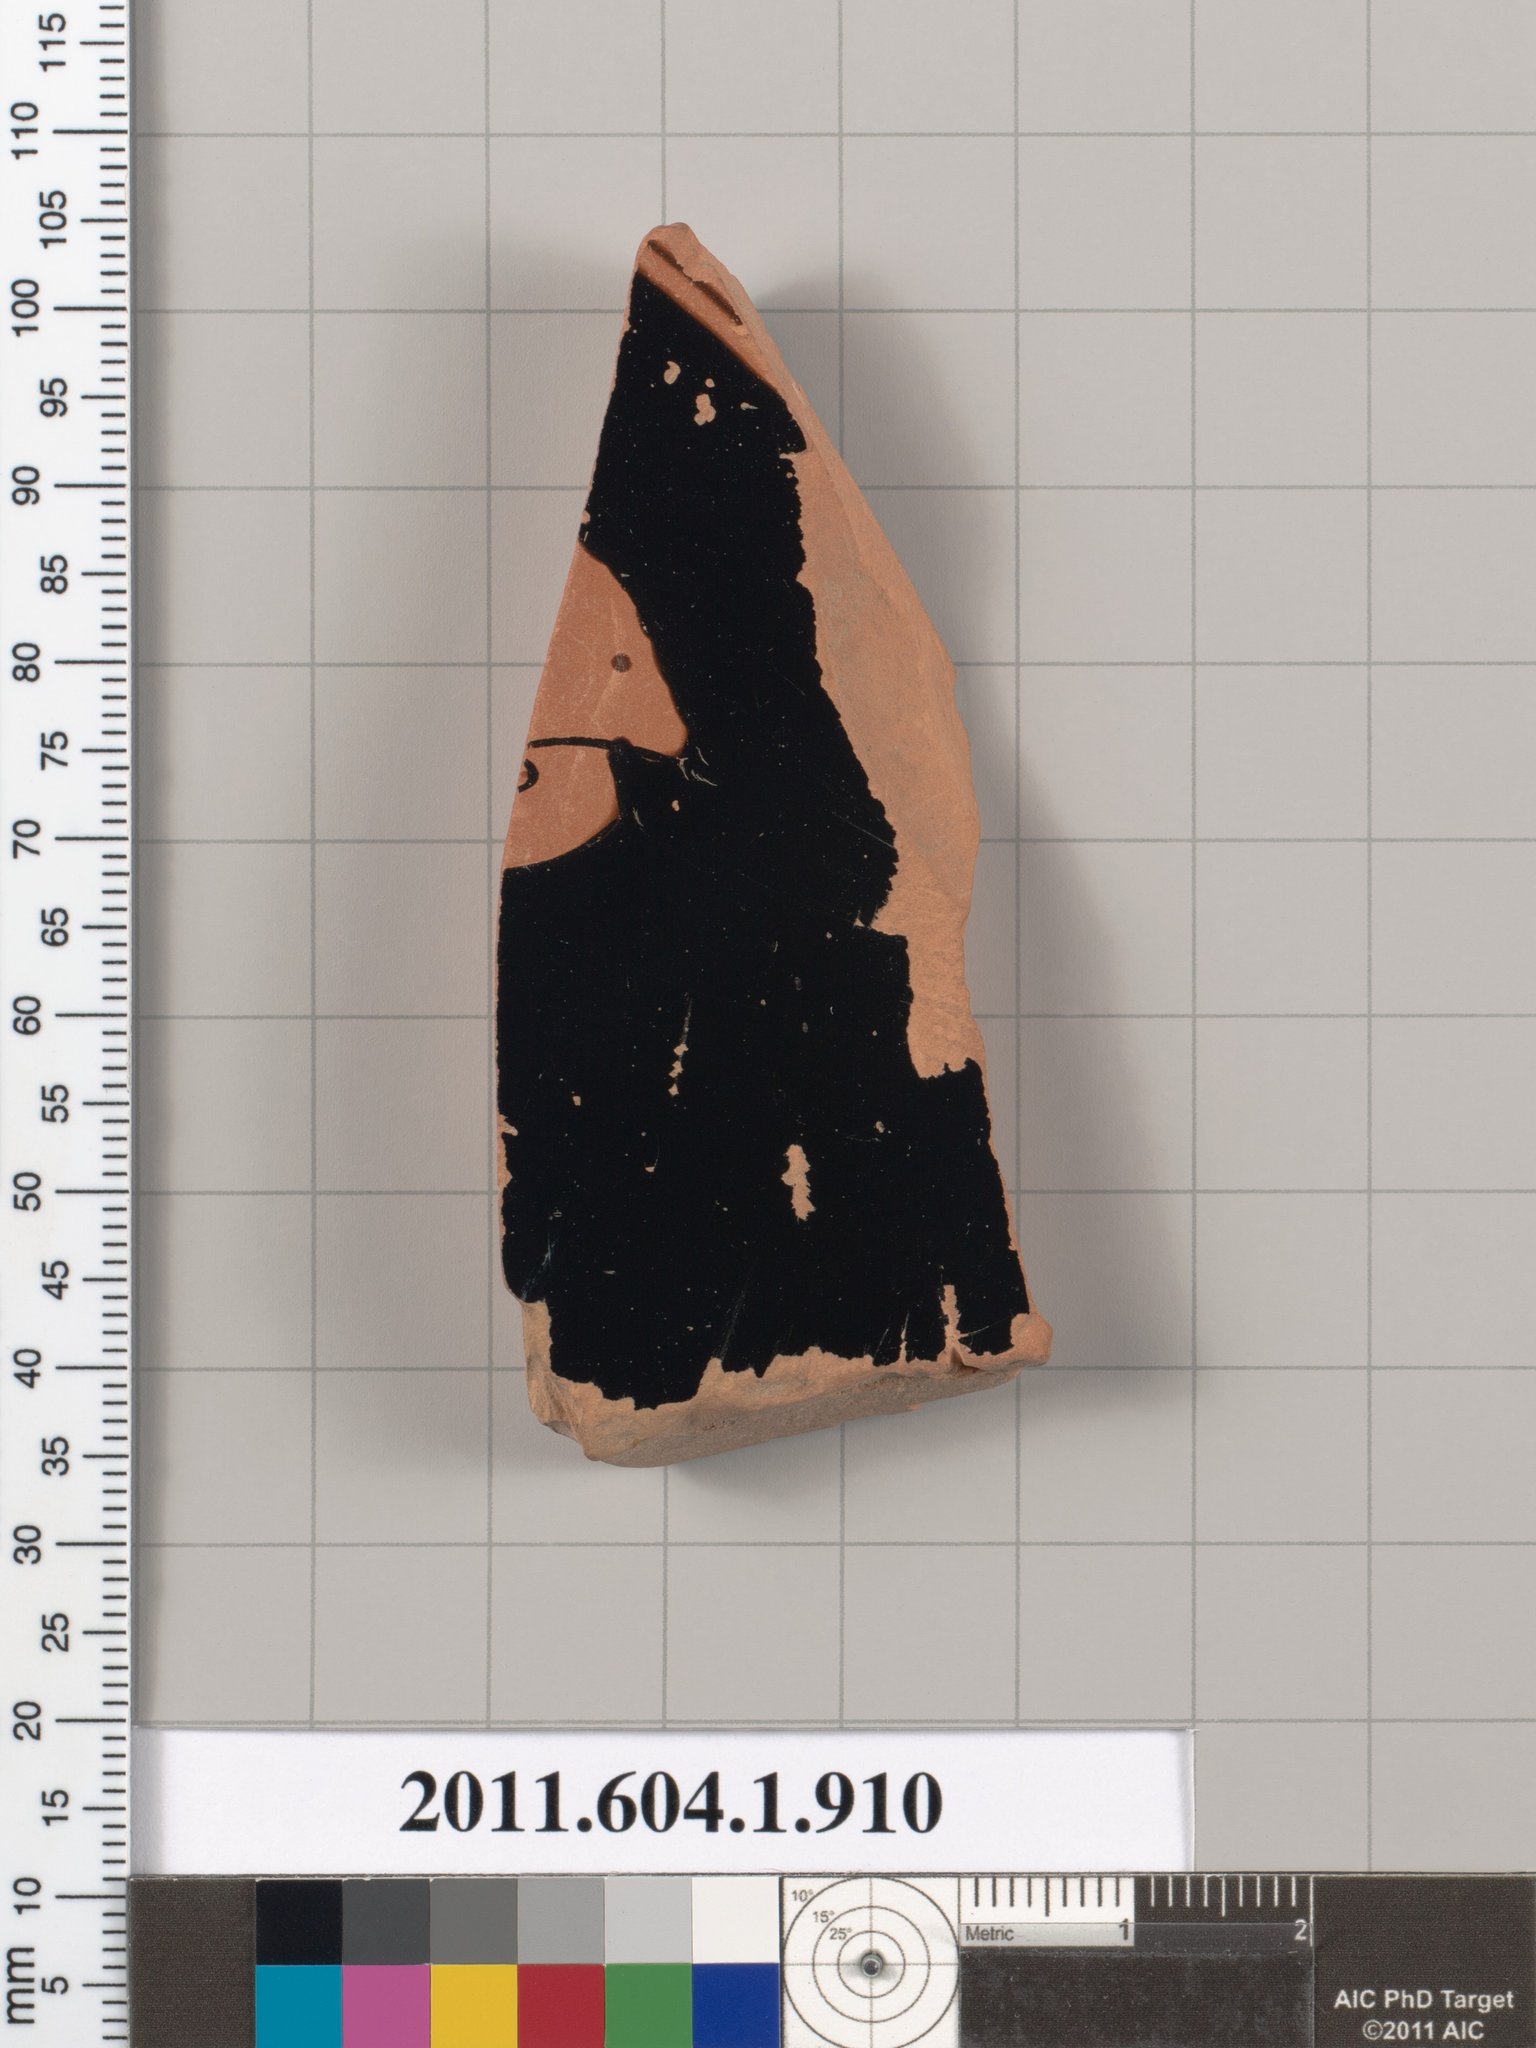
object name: kylix fragment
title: Terracotta fragment of a kylix (drinking cup)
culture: greek, attic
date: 475-451 BCE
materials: terracotta